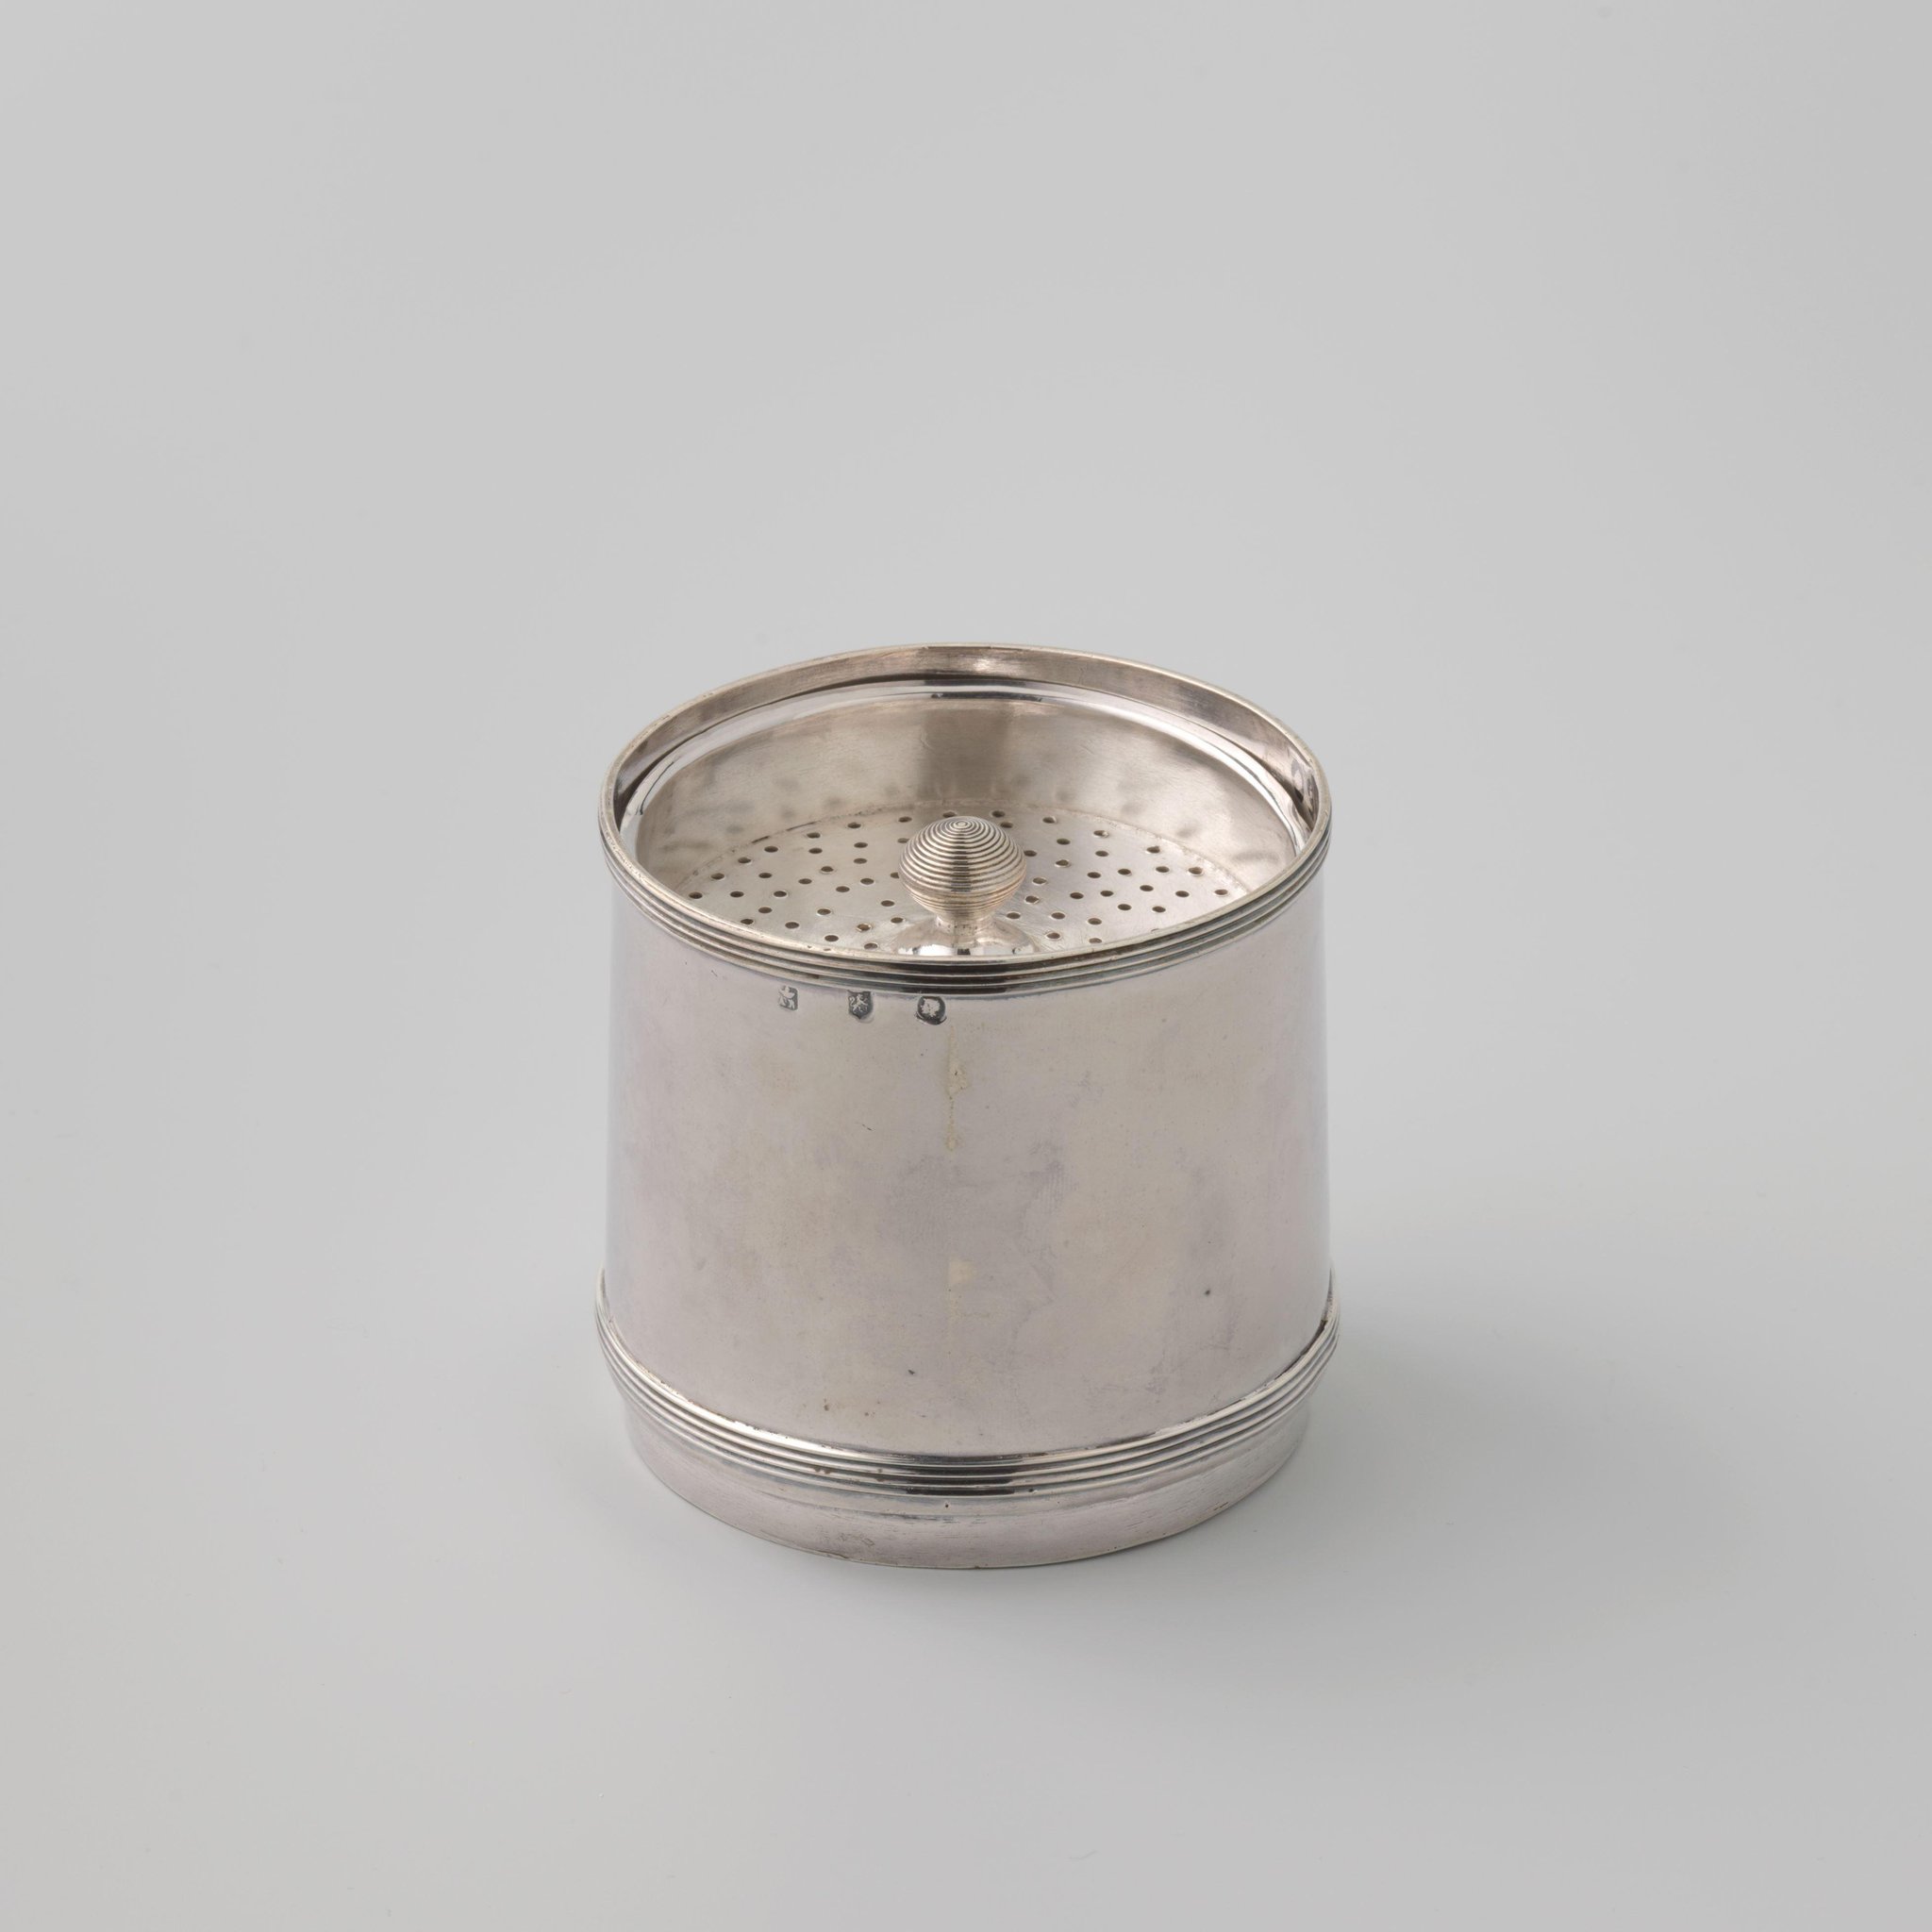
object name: coffee pot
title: Opzetstuk voor koffiefilterkan, cilindrisch, met filetranden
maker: andreas roeloffs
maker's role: silversmith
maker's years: 1800-1862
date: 1845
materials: silver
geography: amsterdam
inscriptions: alloy mark, date letter: ‘L’, maker's mark, assay office mark: ‘Minervakop met A’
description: Het cilindrische opzetstuk heeft een bodem met een groot aantal kleine gaatjes en is uitgerust met een los filter, bestaande uit een bodem met gaatjes, omgeven door een rechte opstaande wand en voorzien van een conisch handvat dat wordt bekroond door een geribde bolvormige knop. Langs de bovenzijde en even onder de onderzijde van het opzetstuk lopen filetranden.